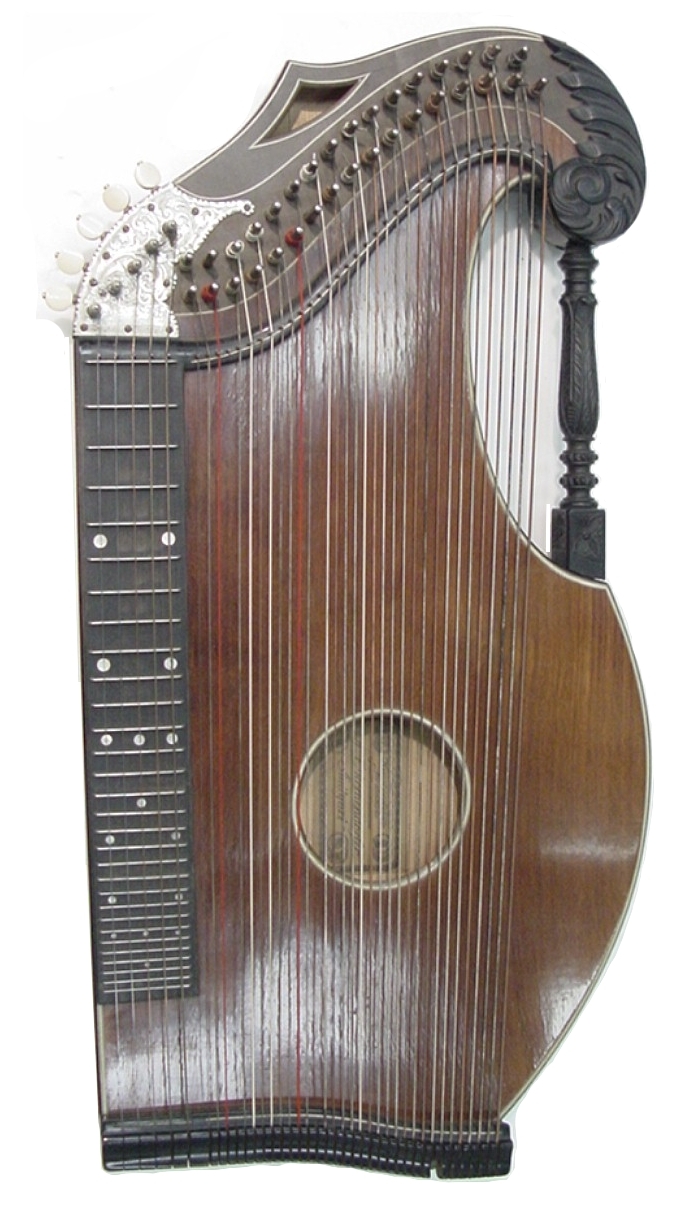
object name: harp zither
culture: german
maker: a. f. kochendorfer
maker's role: maker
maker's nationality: german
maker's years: 1860-1875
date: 1901-1933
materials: metal, wood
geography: germany